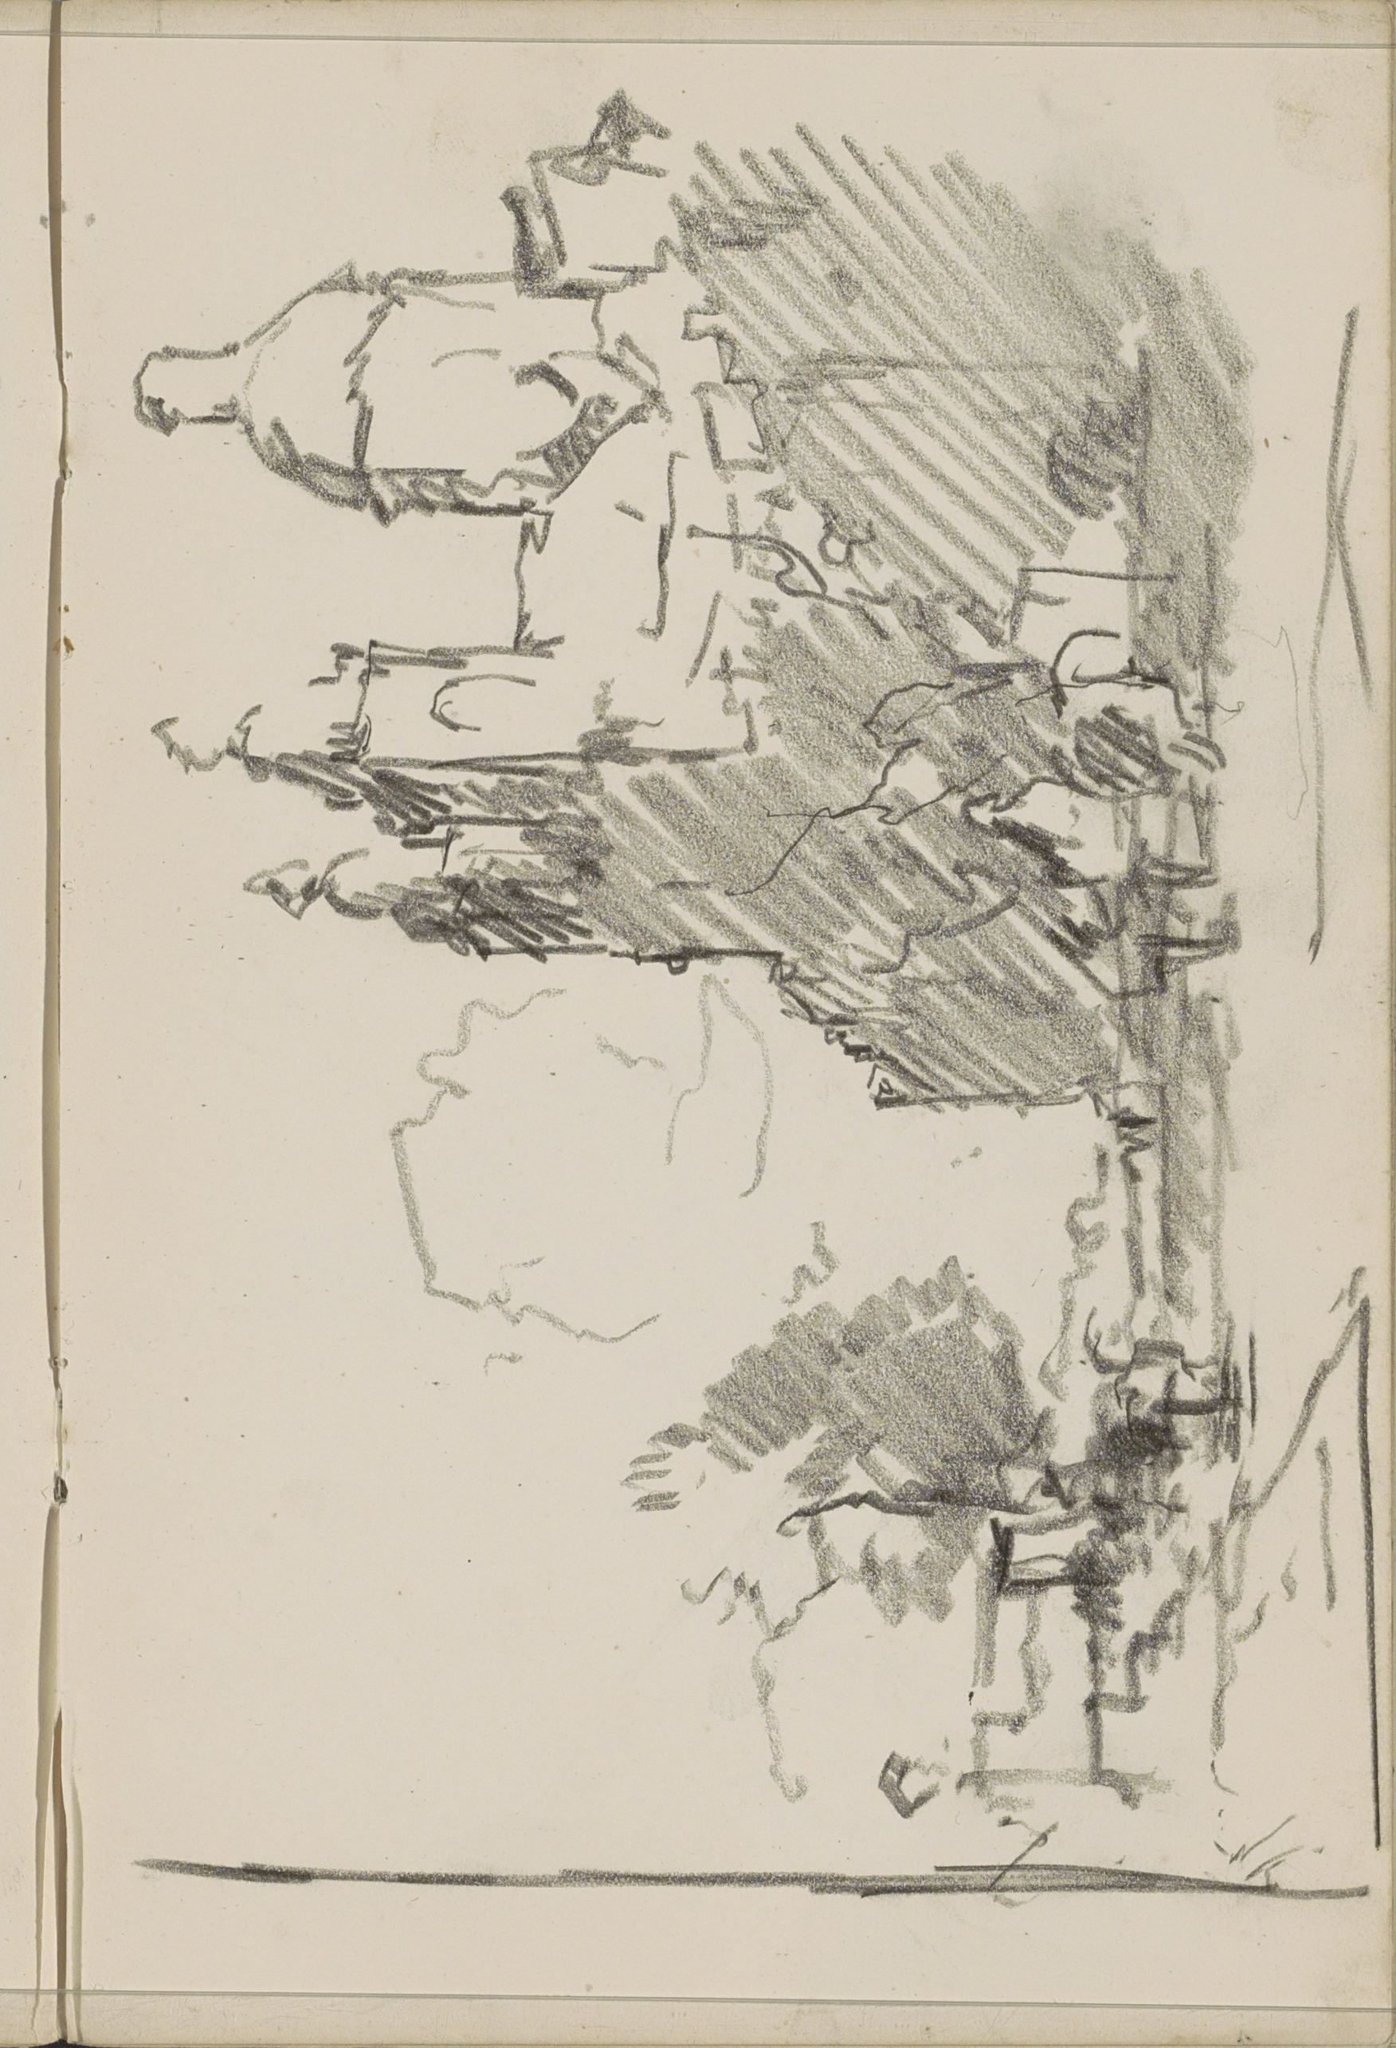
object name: sketchbook leaf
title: Nicolaaskerk te Amsterdam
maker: cornelis vreedenburgh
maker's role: draughtsman, print maker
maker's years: 1880-1946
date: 1890-1946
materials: chalk, paper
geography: amsterdam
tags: church (exterior)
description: Blad 24 recto uit een schetsboek met 47 bladen.